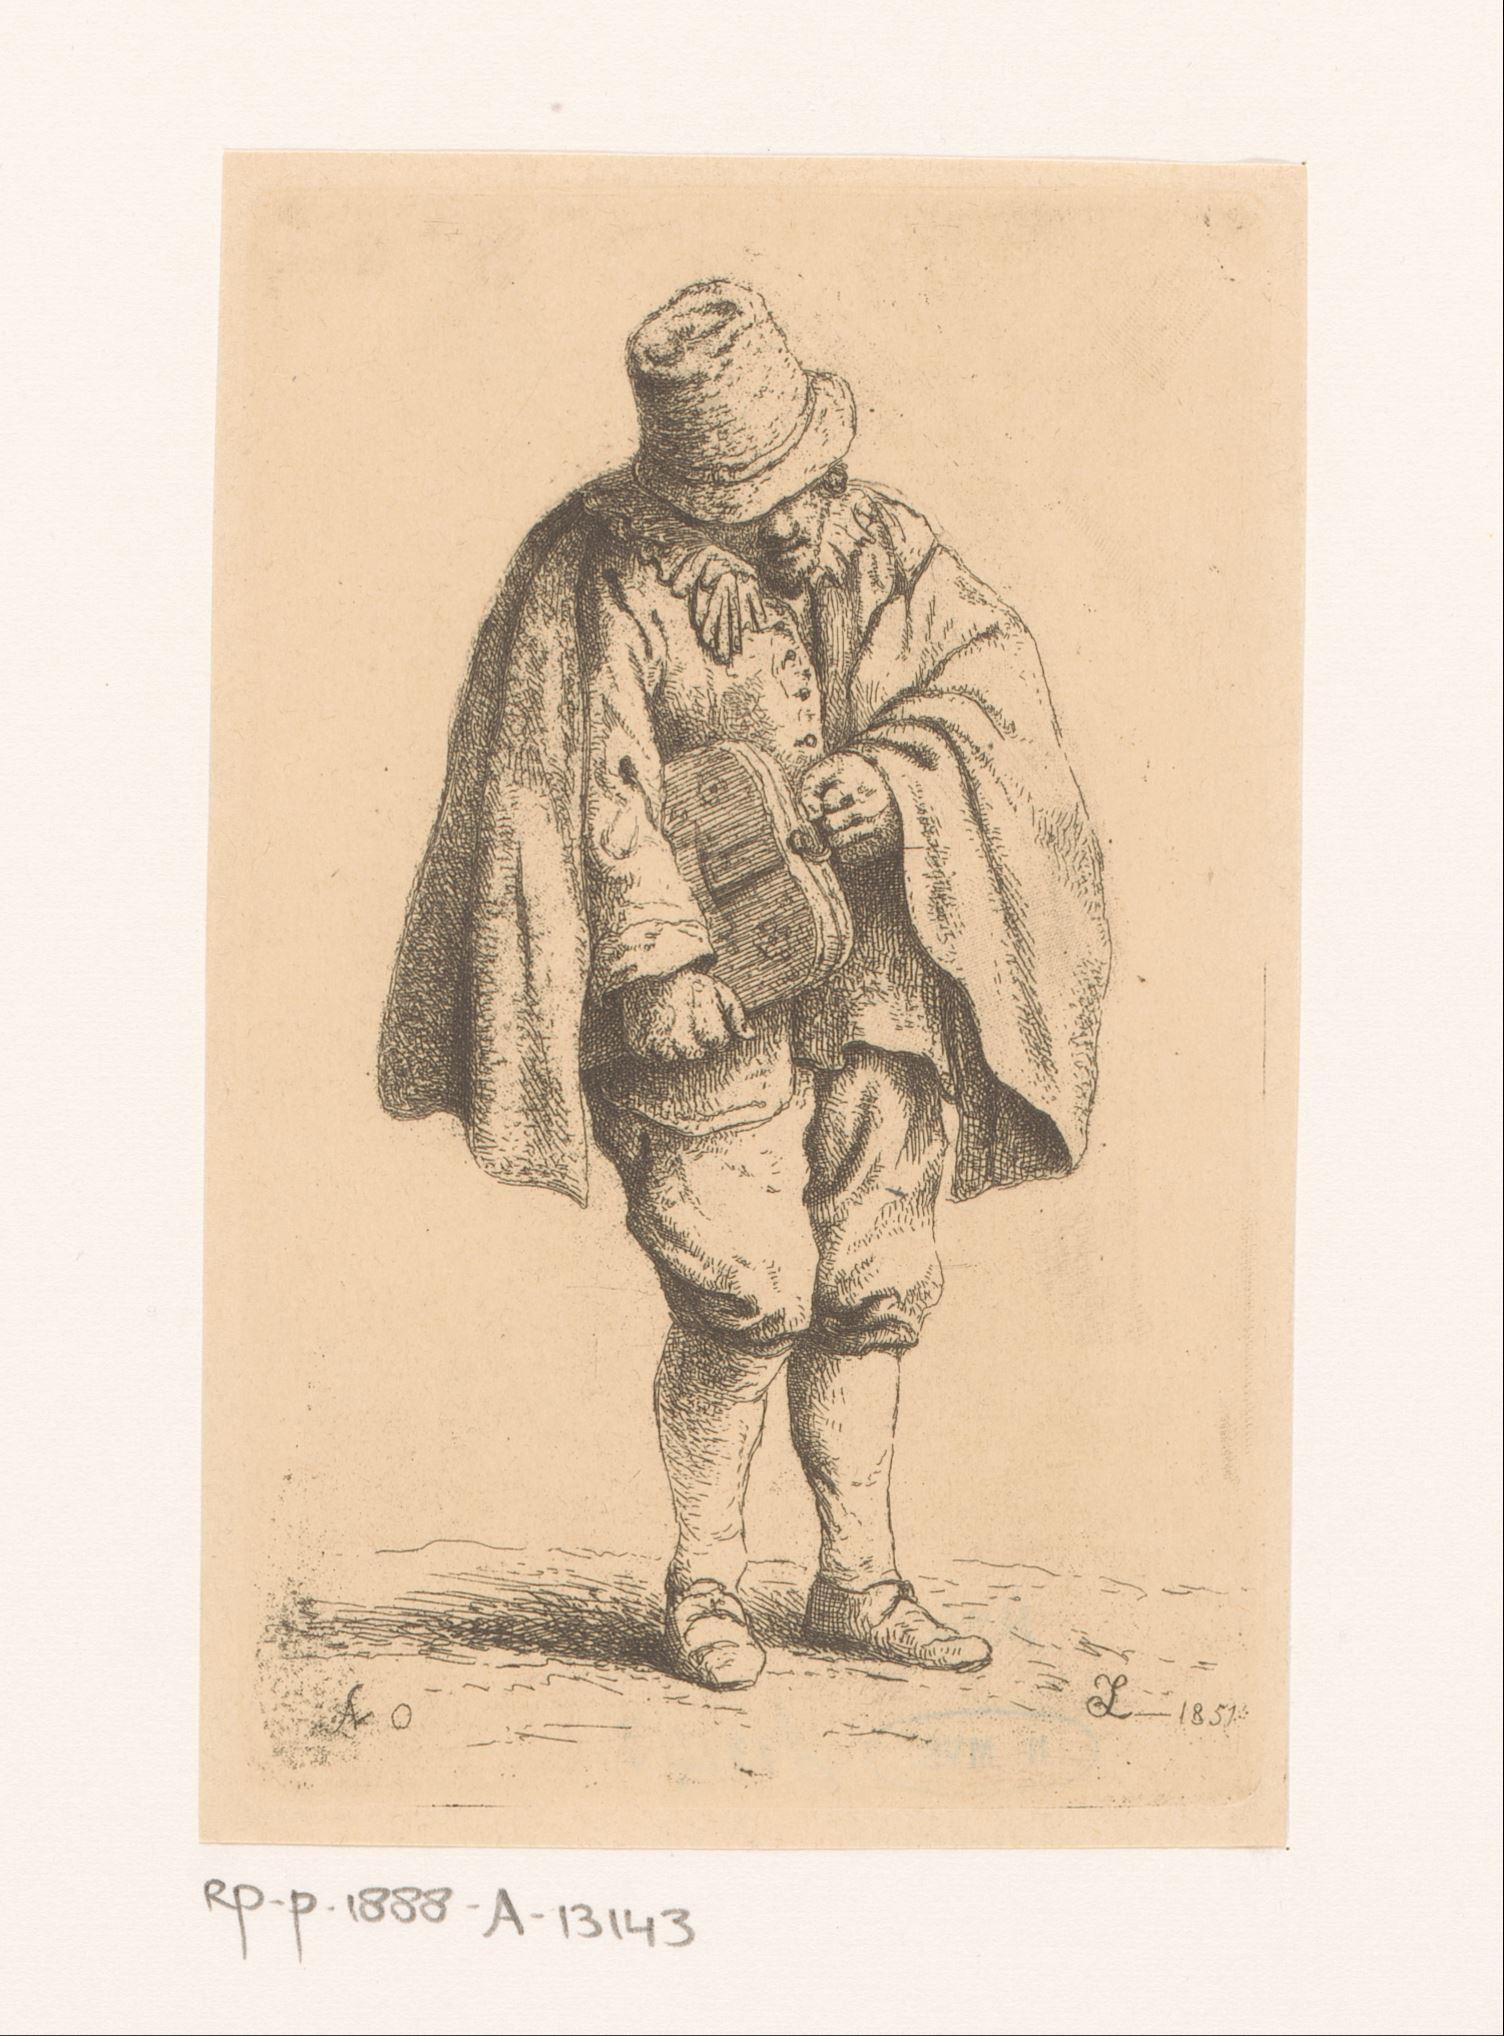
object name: print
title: Straatmuzikant met draailier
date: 1851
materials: paper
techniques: etching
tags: hurdy-gurdy player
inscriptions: collector's mark: Lugt 2228